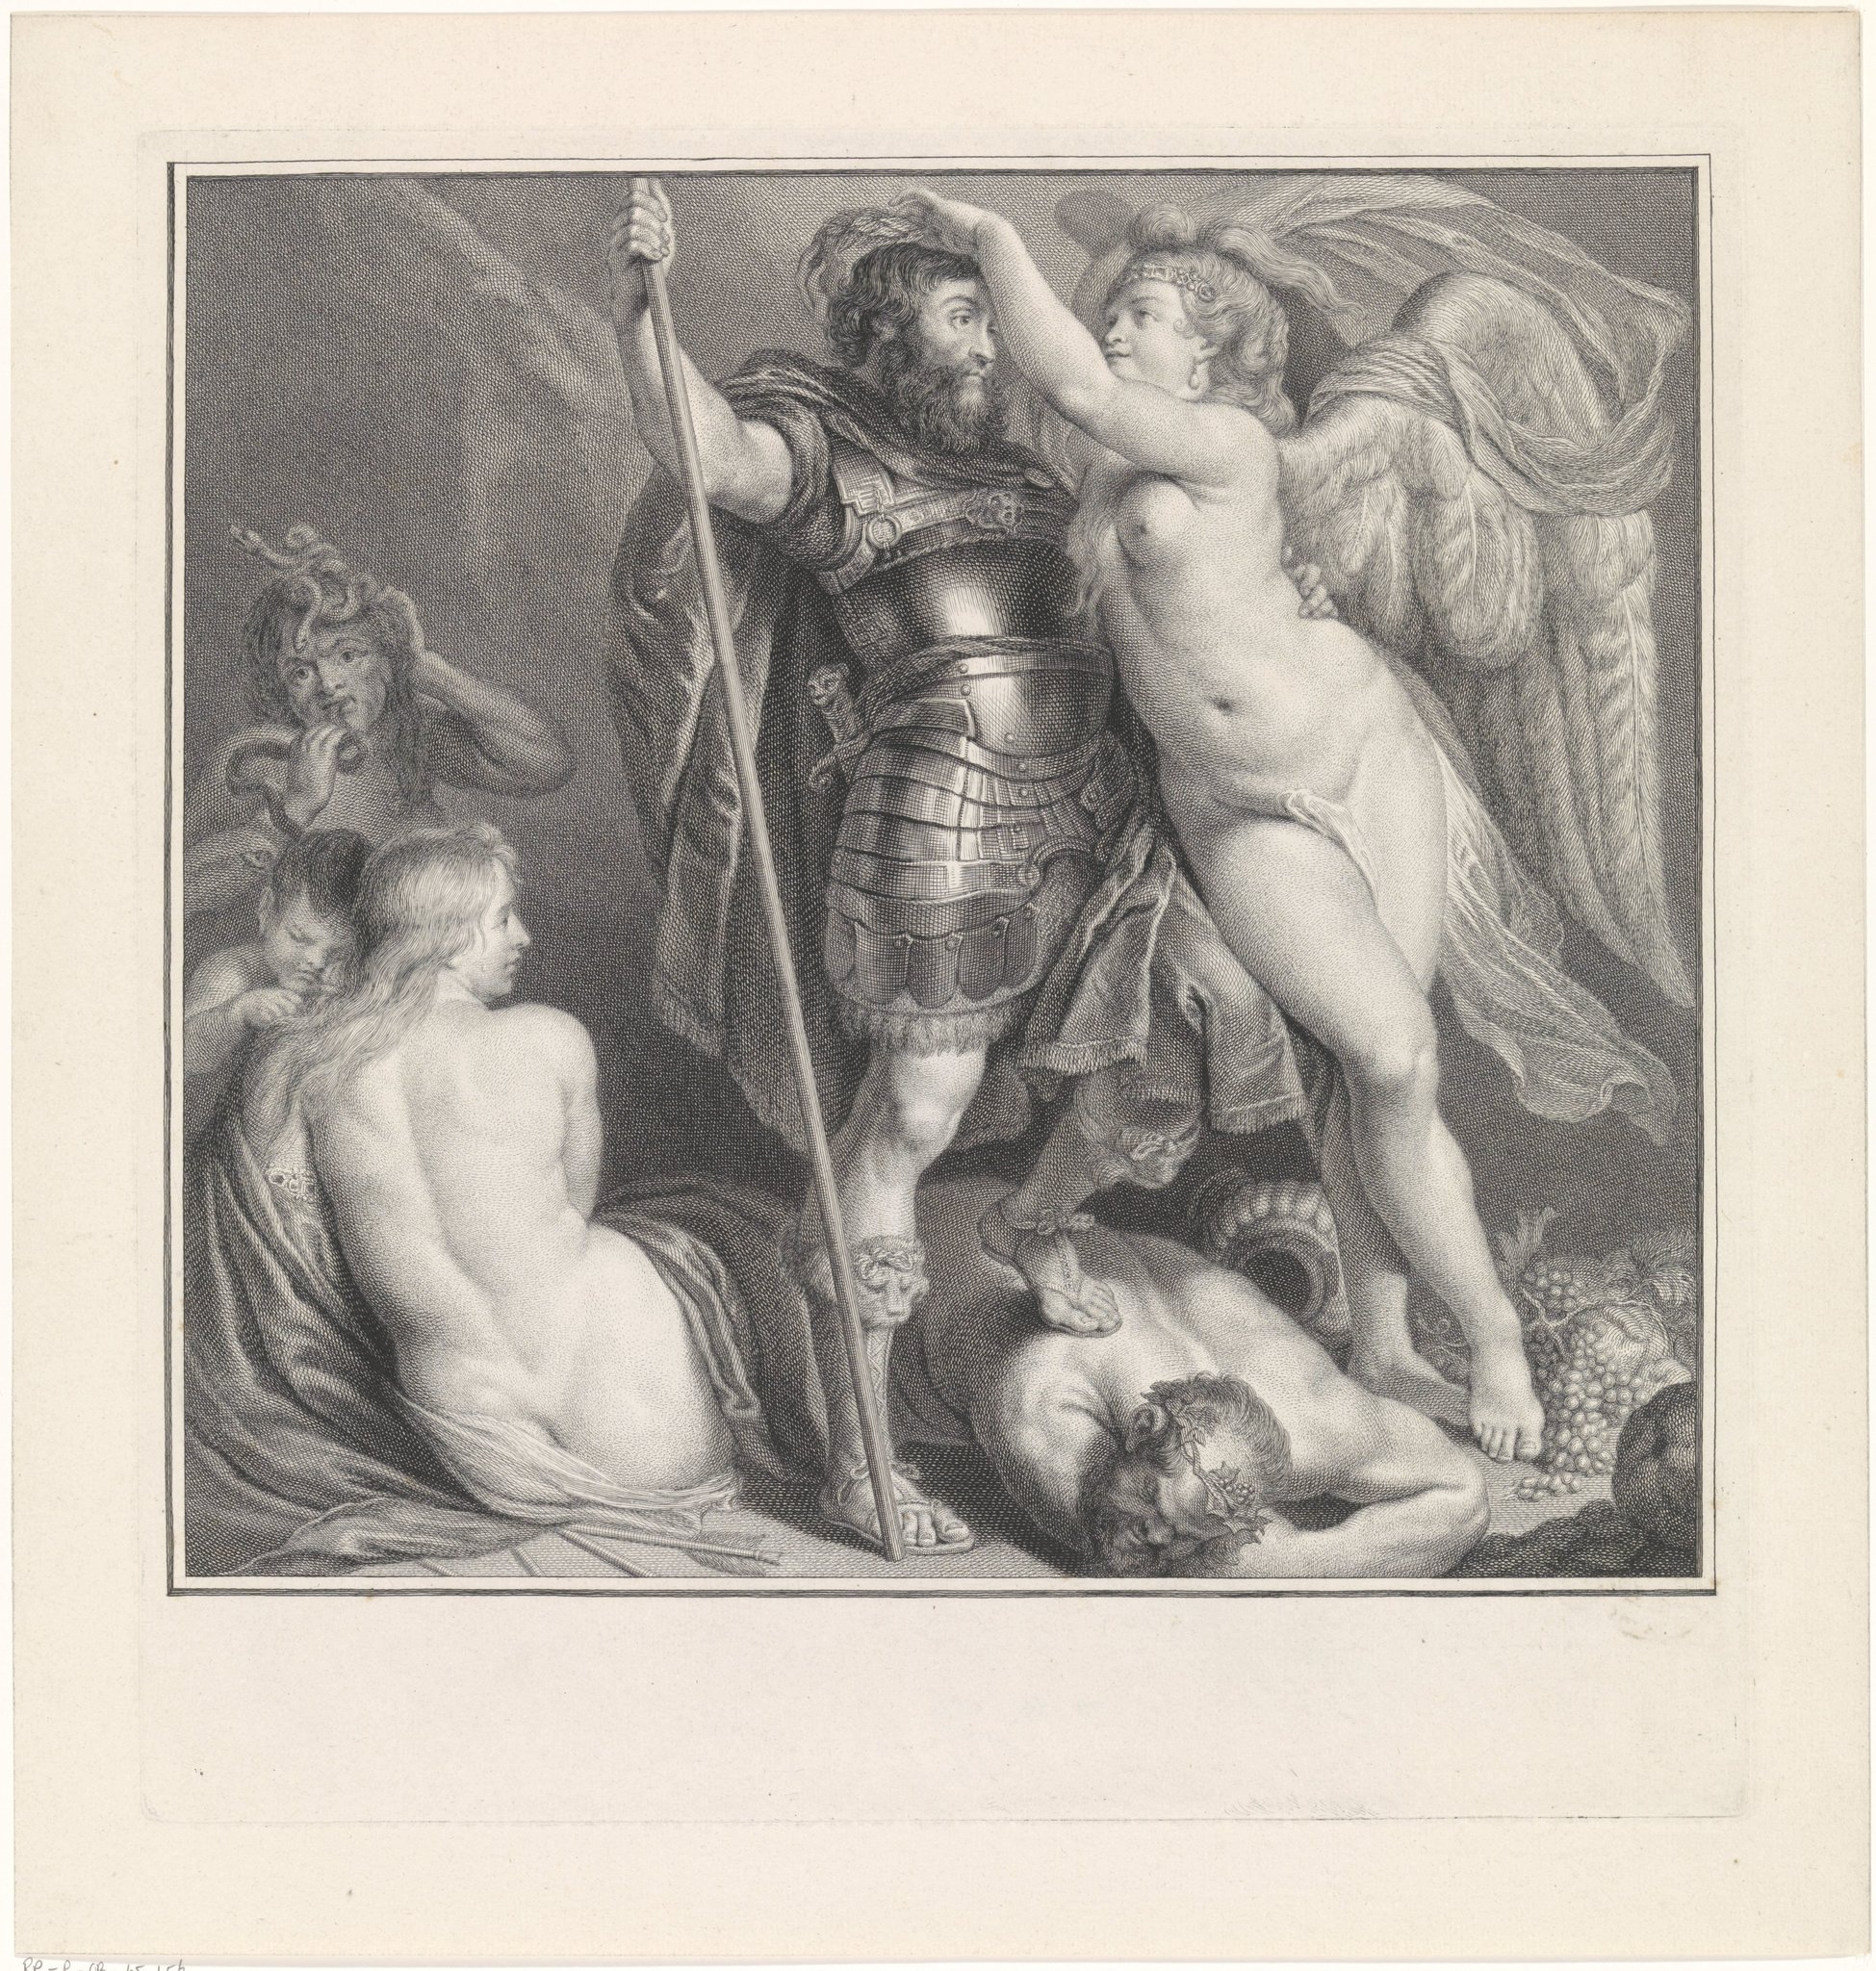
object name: print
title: Victoria kroont een deugdzame held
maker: pieter tanjé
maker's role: draughtsman, print maker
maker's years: 1706-1761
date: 1716-1761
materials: paper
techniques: engraving, etching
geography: amsterdam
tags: (story of) bacchus (dionysus), liber, 'victoria'; 'vittoria', 'vittoria navale', 'vittoria degl'antichi' (ripa), crowning with laurel, rage, anger, venus and cupid (cupid not being mere attribute)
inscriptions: collector's mark: Lugt 240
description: De godin van de overwinning, Victoria, zet een lauwerkrans op het hoofd van een deugdzame gaharnaste held. De held heeft drank, genotzucht en nijd overwonnen. Hij staat met zijn voet op Bacchus, de god van de wijn. Achter hem zitten de treurende Venus en Amor en staat de Nijd.